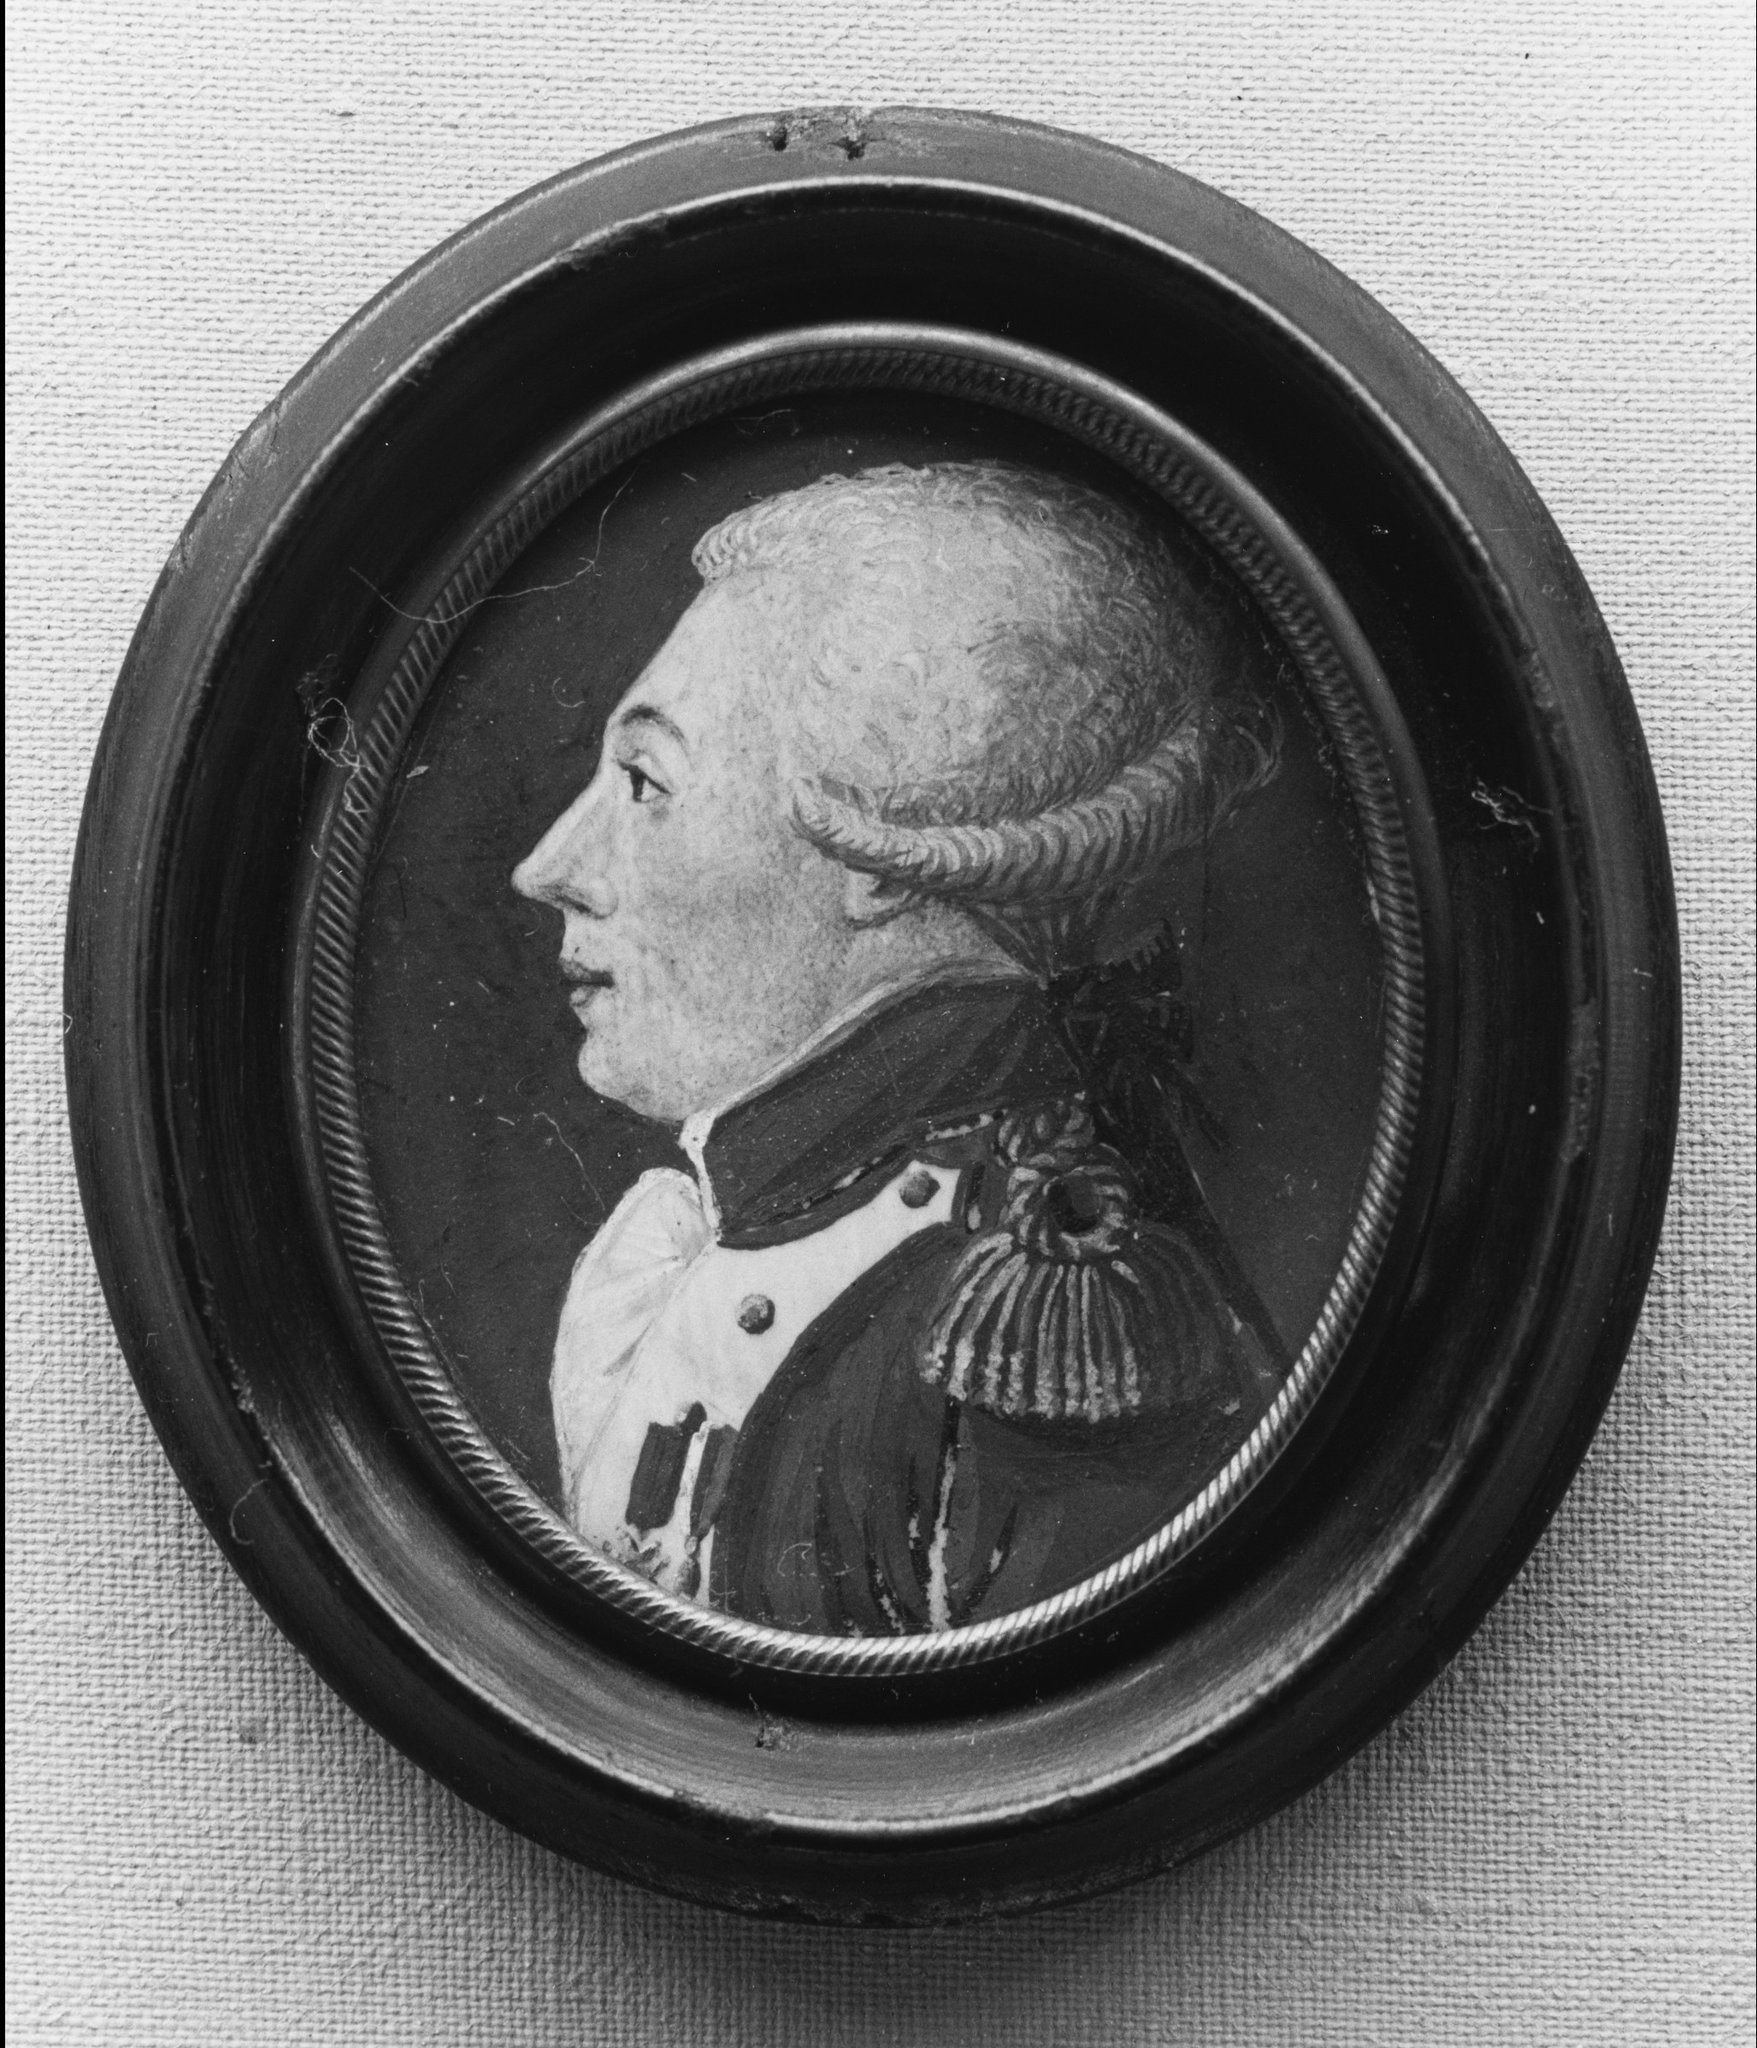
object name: painting, miniature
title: Portrait Miniature of the Marquis de Lafayette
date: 1775-1883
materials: parchment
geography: france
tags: men,portraits,profiles,marquis de lafayette